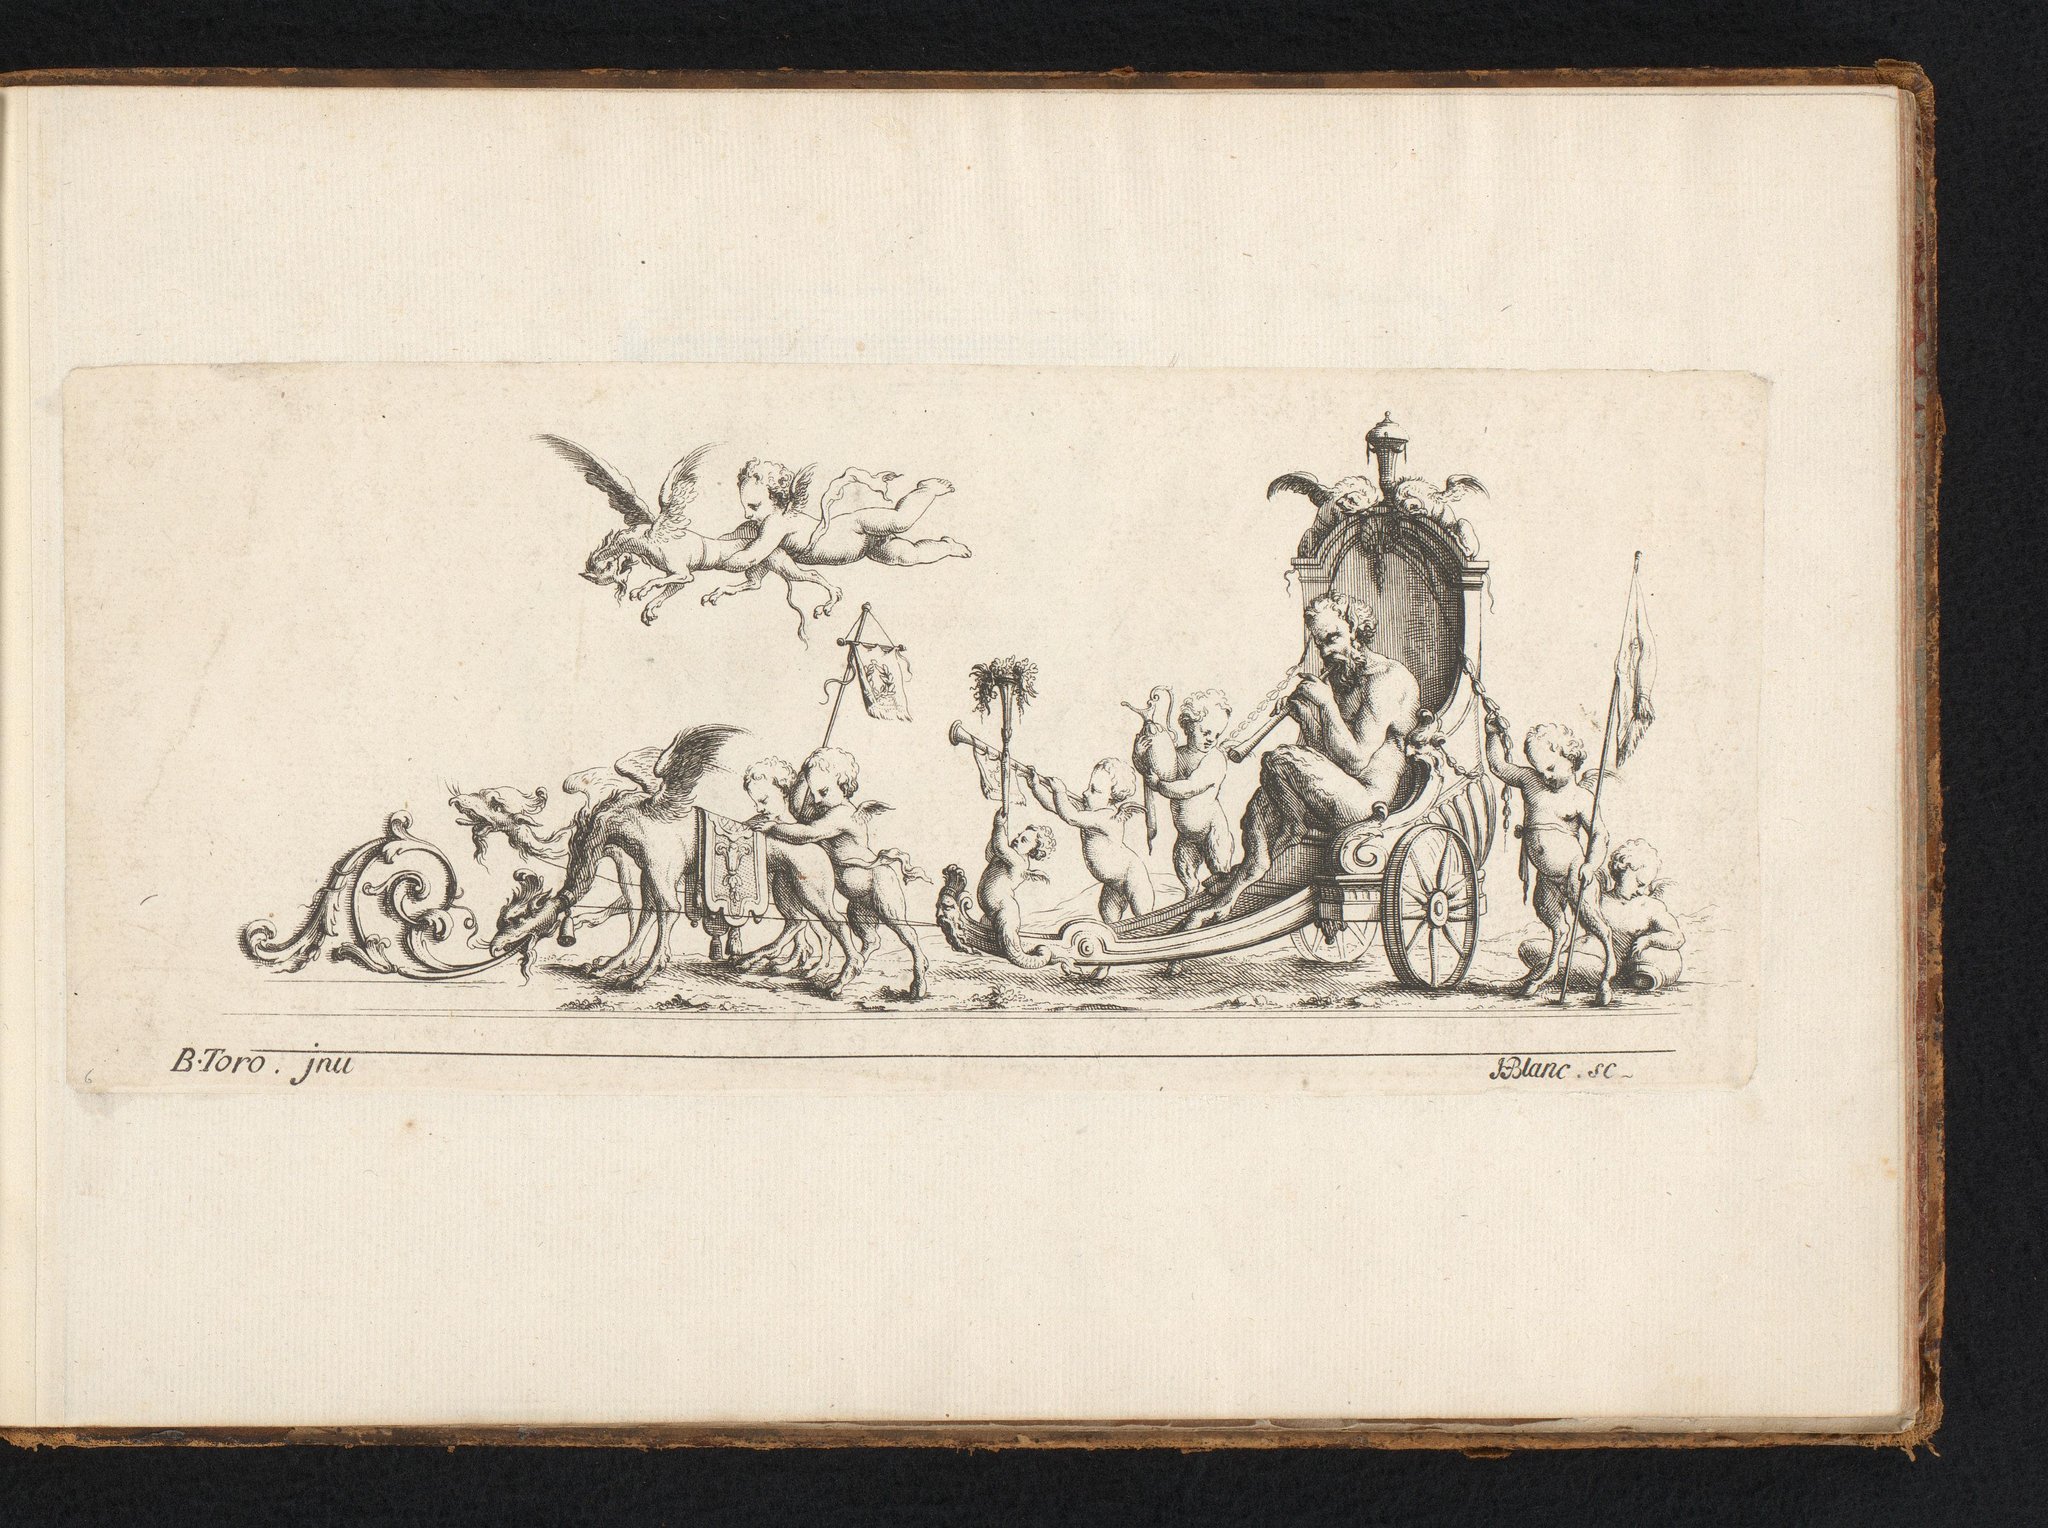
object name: ornament print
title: Optocht met Pan in een triomfwagen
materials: paper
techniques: etching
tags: chariot, triumphal car, (story of) pan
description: Prent maakt deel uit van een serie van zes prenten.